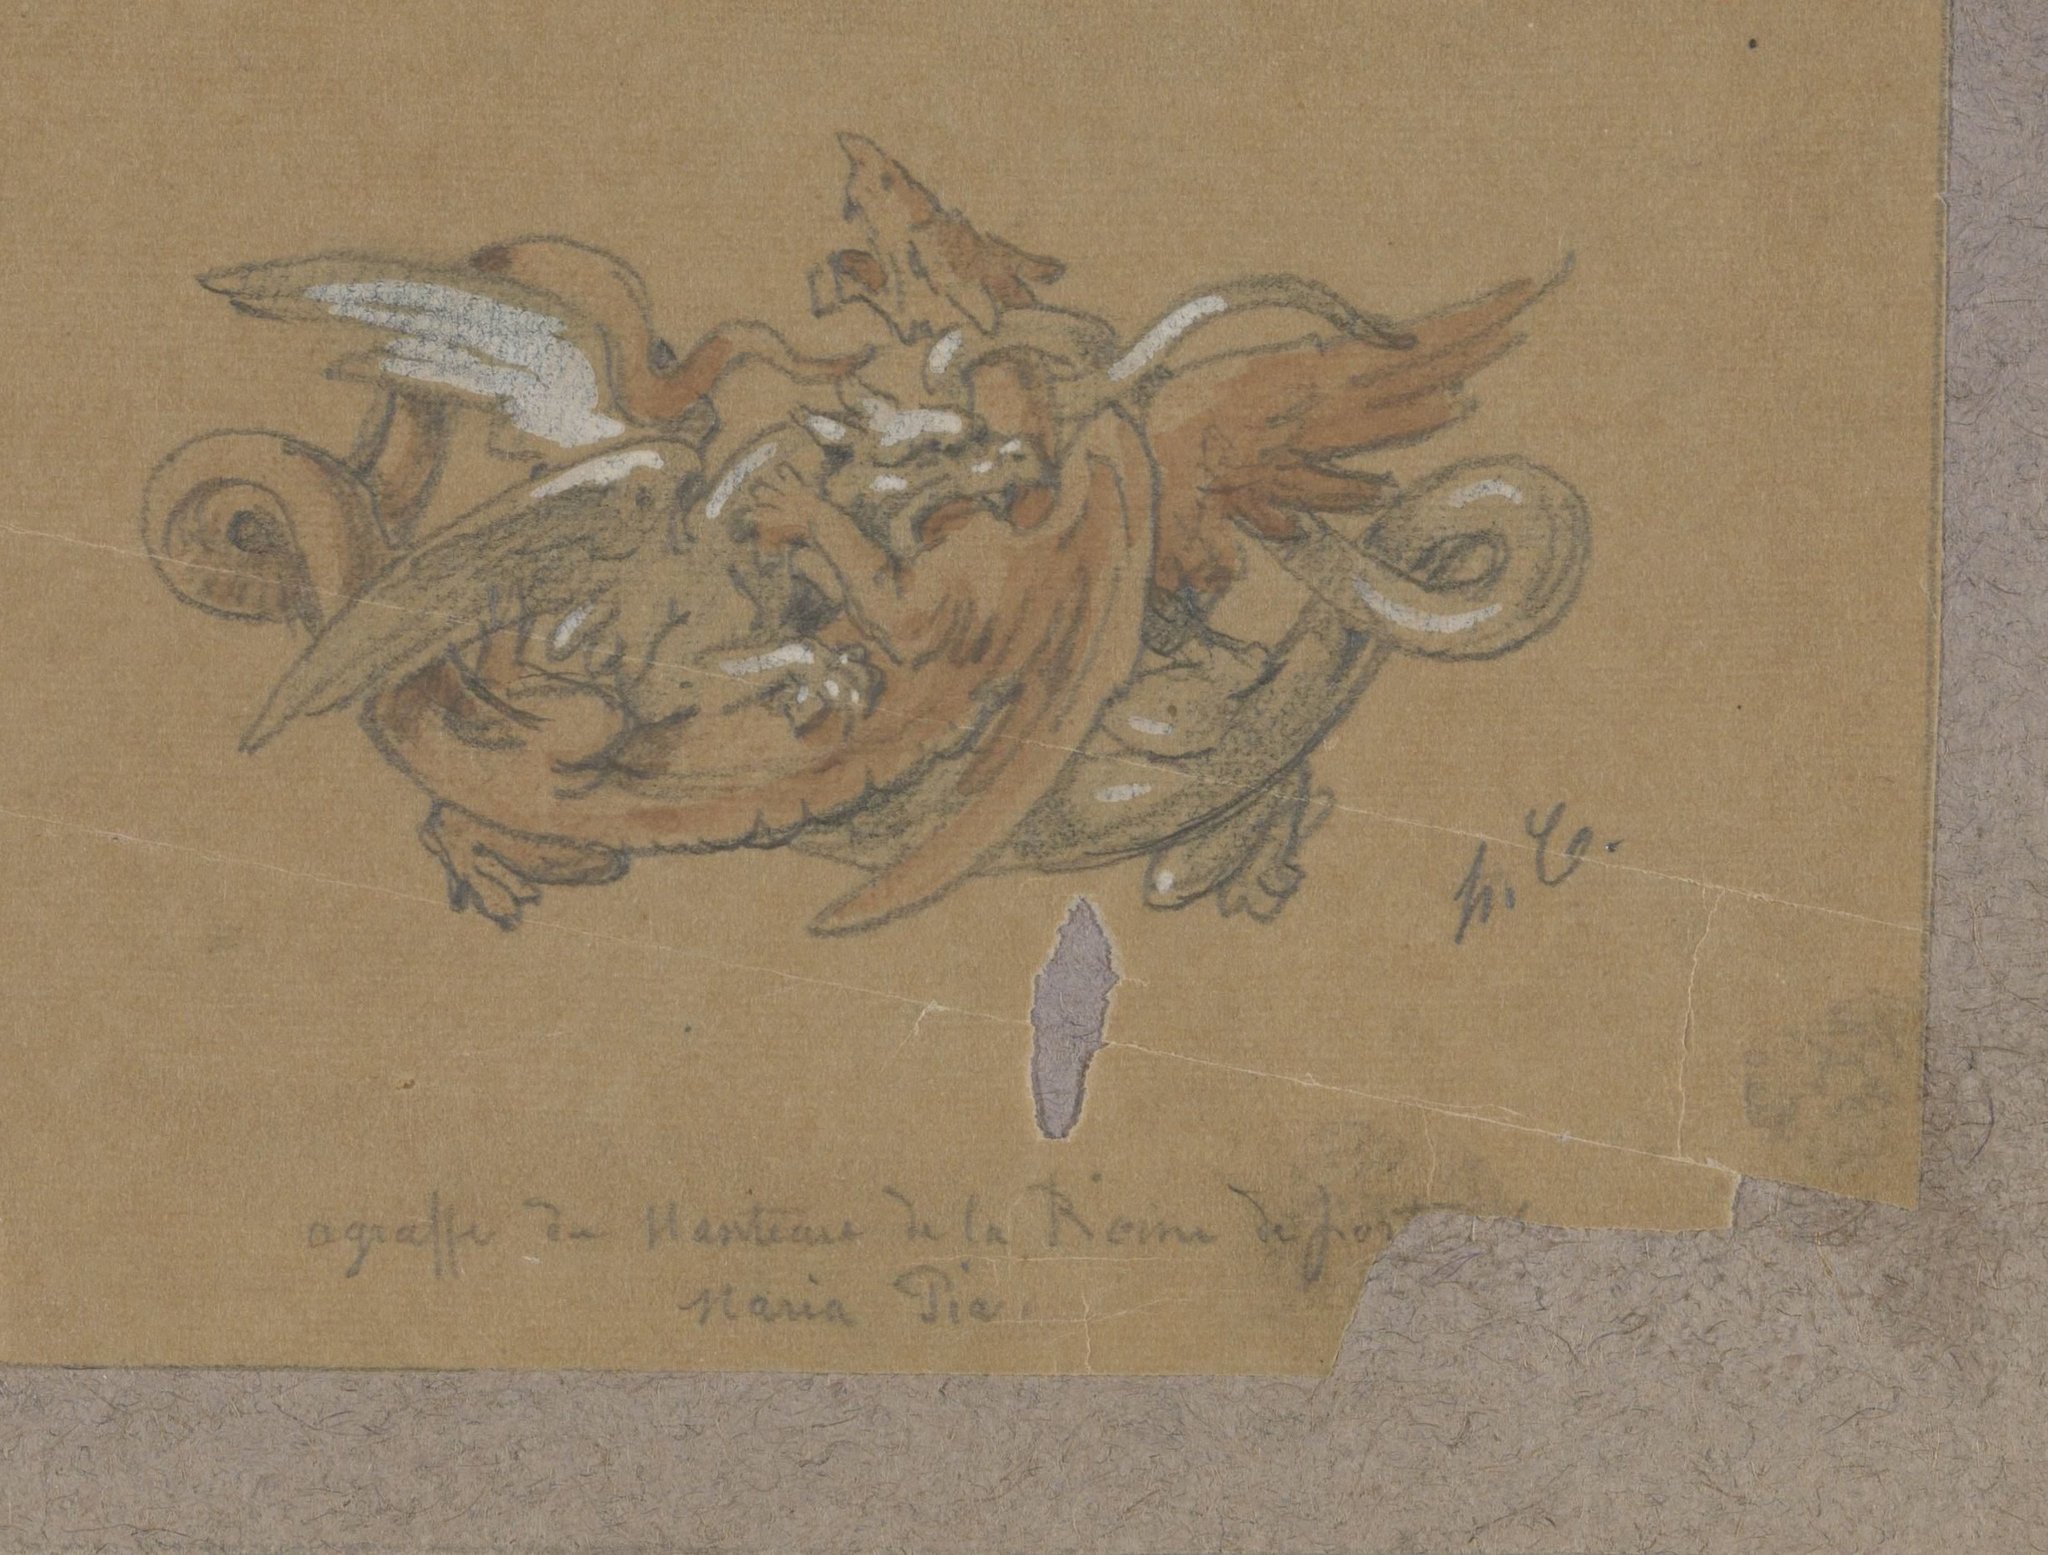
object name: design drawing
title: Design for a Buckle in the Shape of Two Fighting Chimeras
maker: henri cameré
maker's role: designer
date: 1864-1894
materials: paint, pencil, paper, watercolor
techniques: brush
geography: paris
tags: brooch, agraffe, clasp, chimera (lion/goat/snake); 'chimera' (ripa)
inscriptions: inscription: ‘agraffe du Manteau de la Reinie de Port[…] / Maria Pia’, caption: ‘Agrafe du manteau de la Reine Maria Pia de Portugal’, signature: ‘h.C.’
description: A pencil note on this design drawing states that this buckle was designed for Maria Pia of Savoy, Queen of Portugal from 1862. It is known from sources that Cameré also designed a silver centrepiece in the form of a galleon presented to her by the city of Paris on the occasion of her wedding. Was this buckle also a gift?